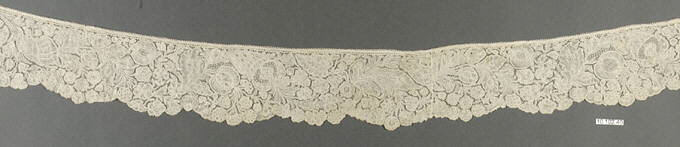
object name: fragment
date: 1701-1733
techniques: lace